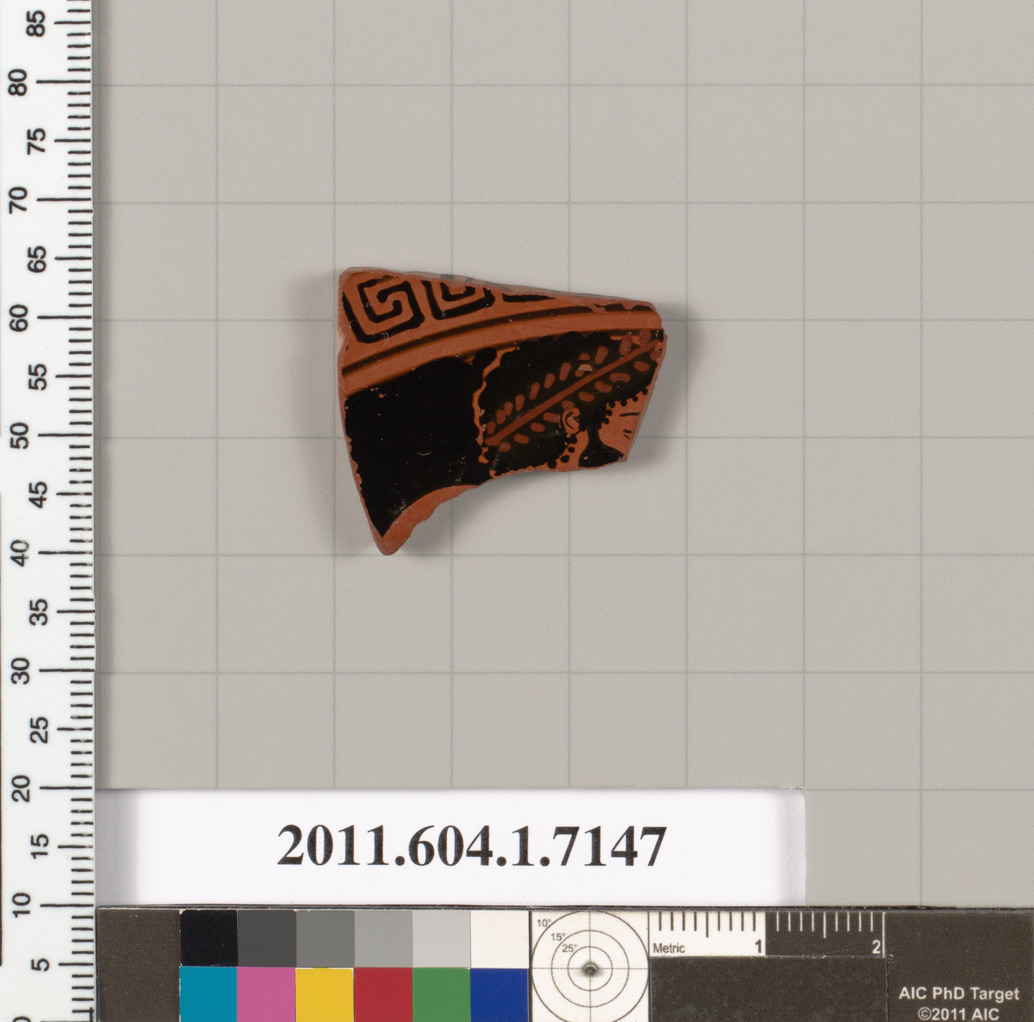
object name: kylix fragment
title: Terracotta fragment of a kylix (drinking cup)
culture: greek, attic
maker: makron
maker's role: artist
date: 500-480 BCE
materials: terracotta